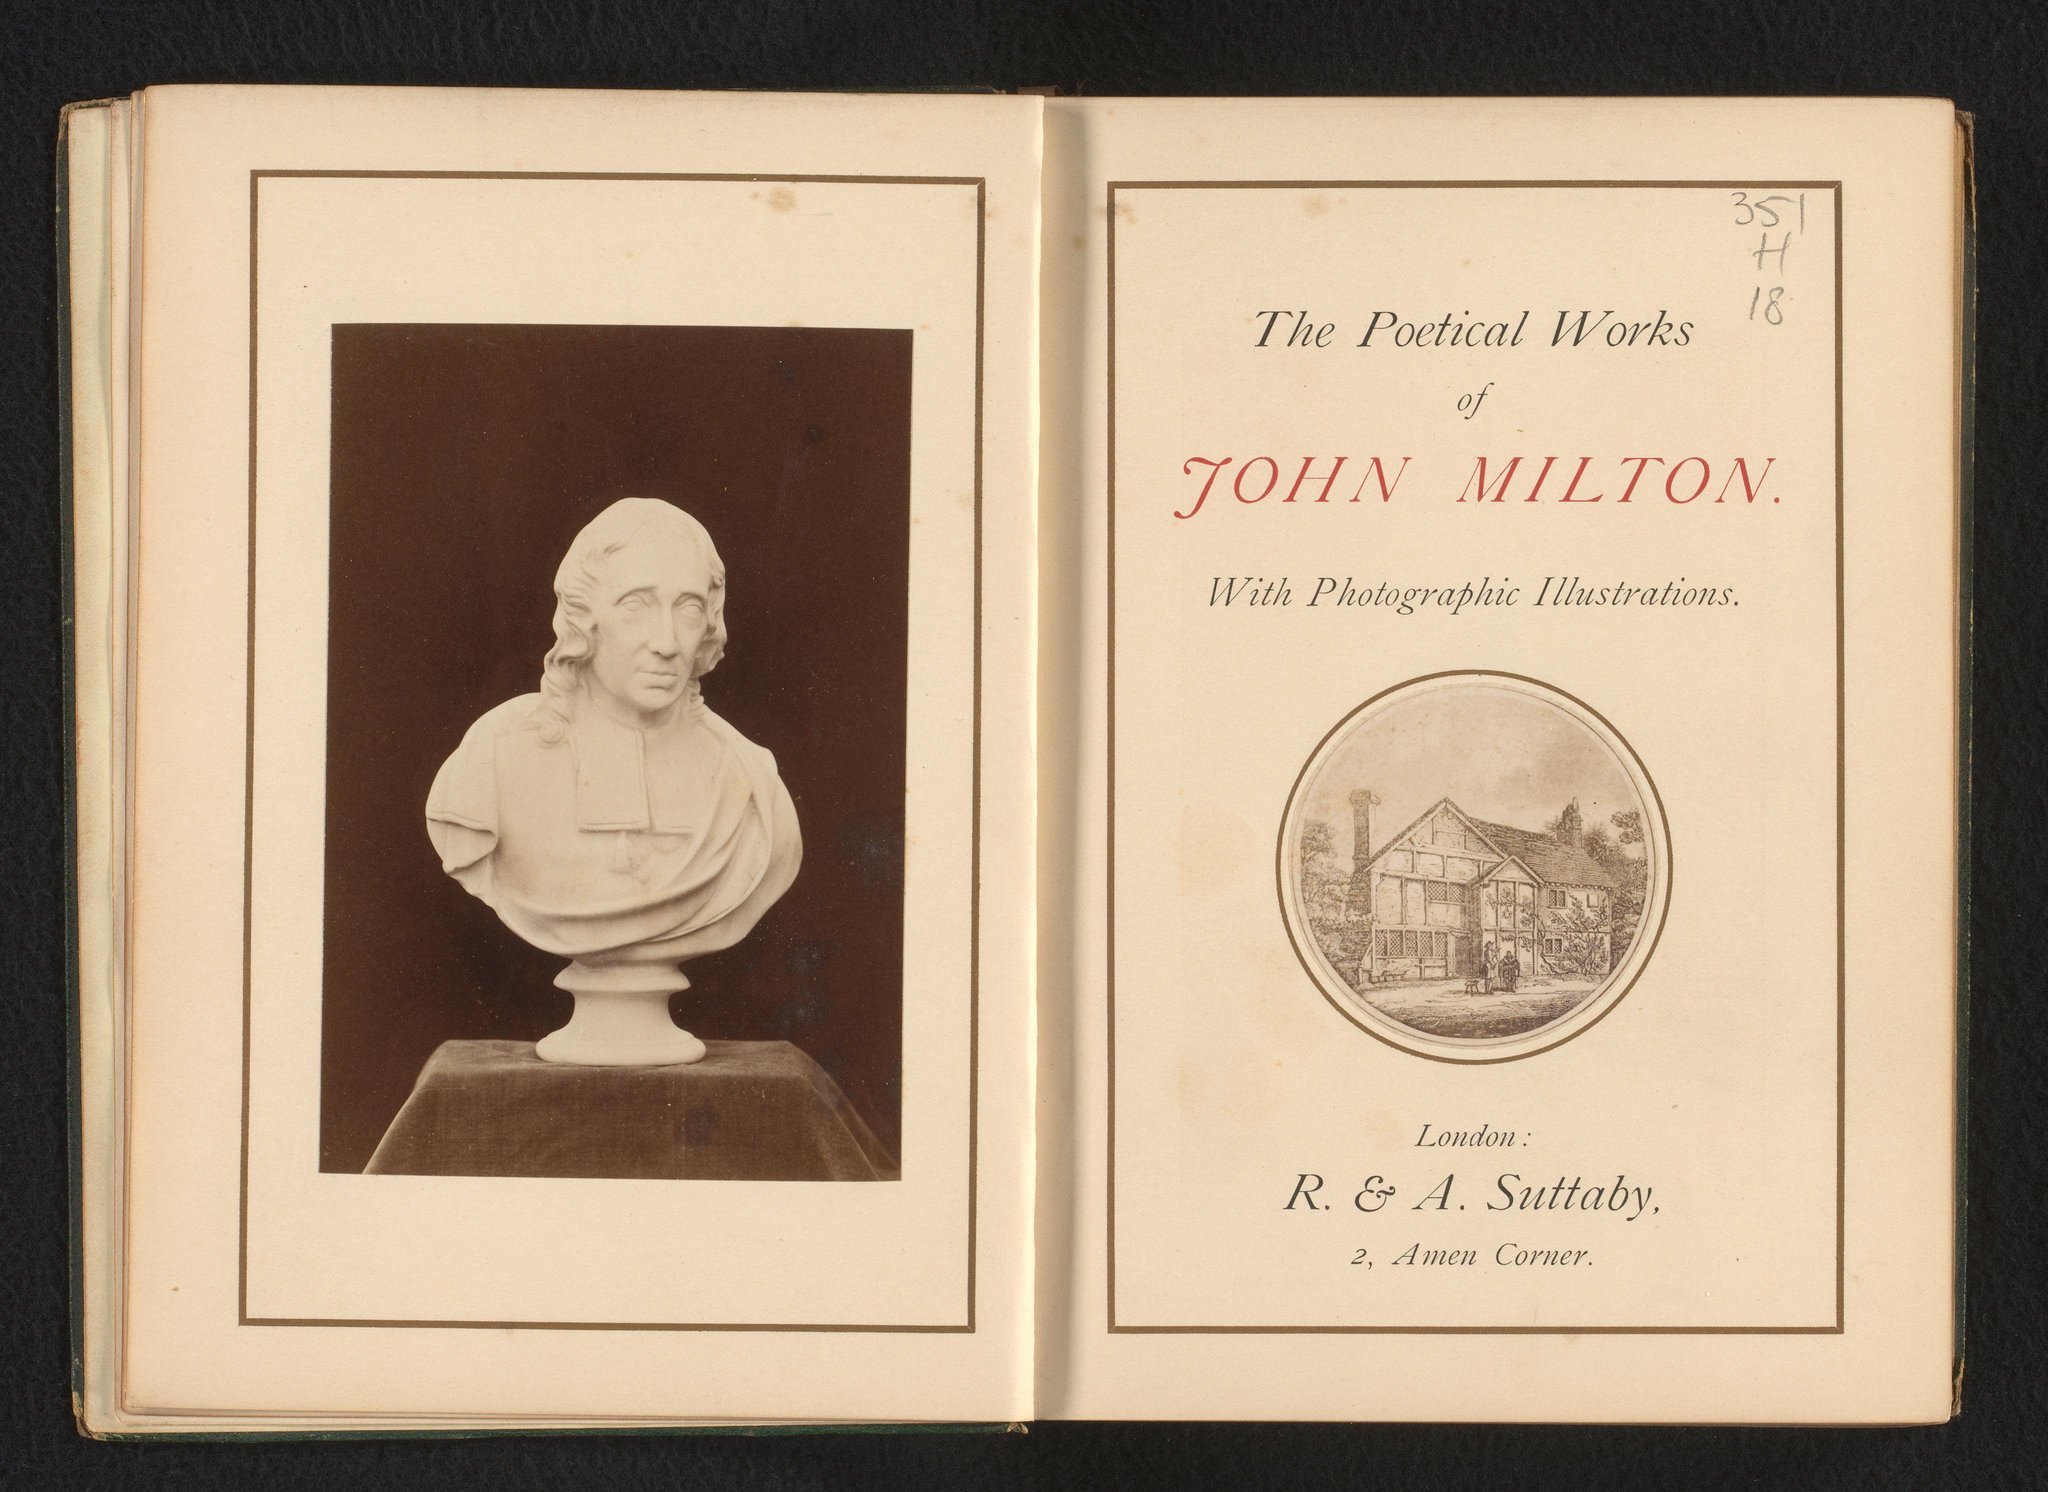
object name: reproduction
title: Fotoreproductie van een tekening van een huis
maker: Anonymous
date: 1866-1890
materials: paper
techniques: albumen print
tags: drawing, cottage